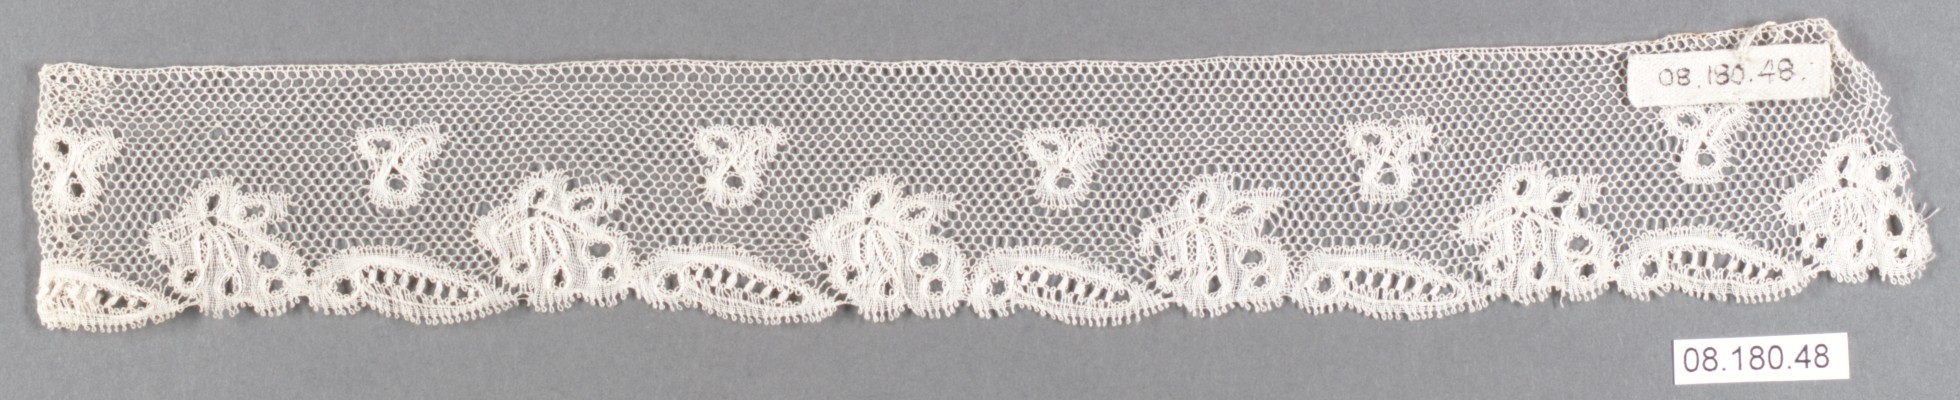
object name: fragment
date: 1801-1900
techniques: lace